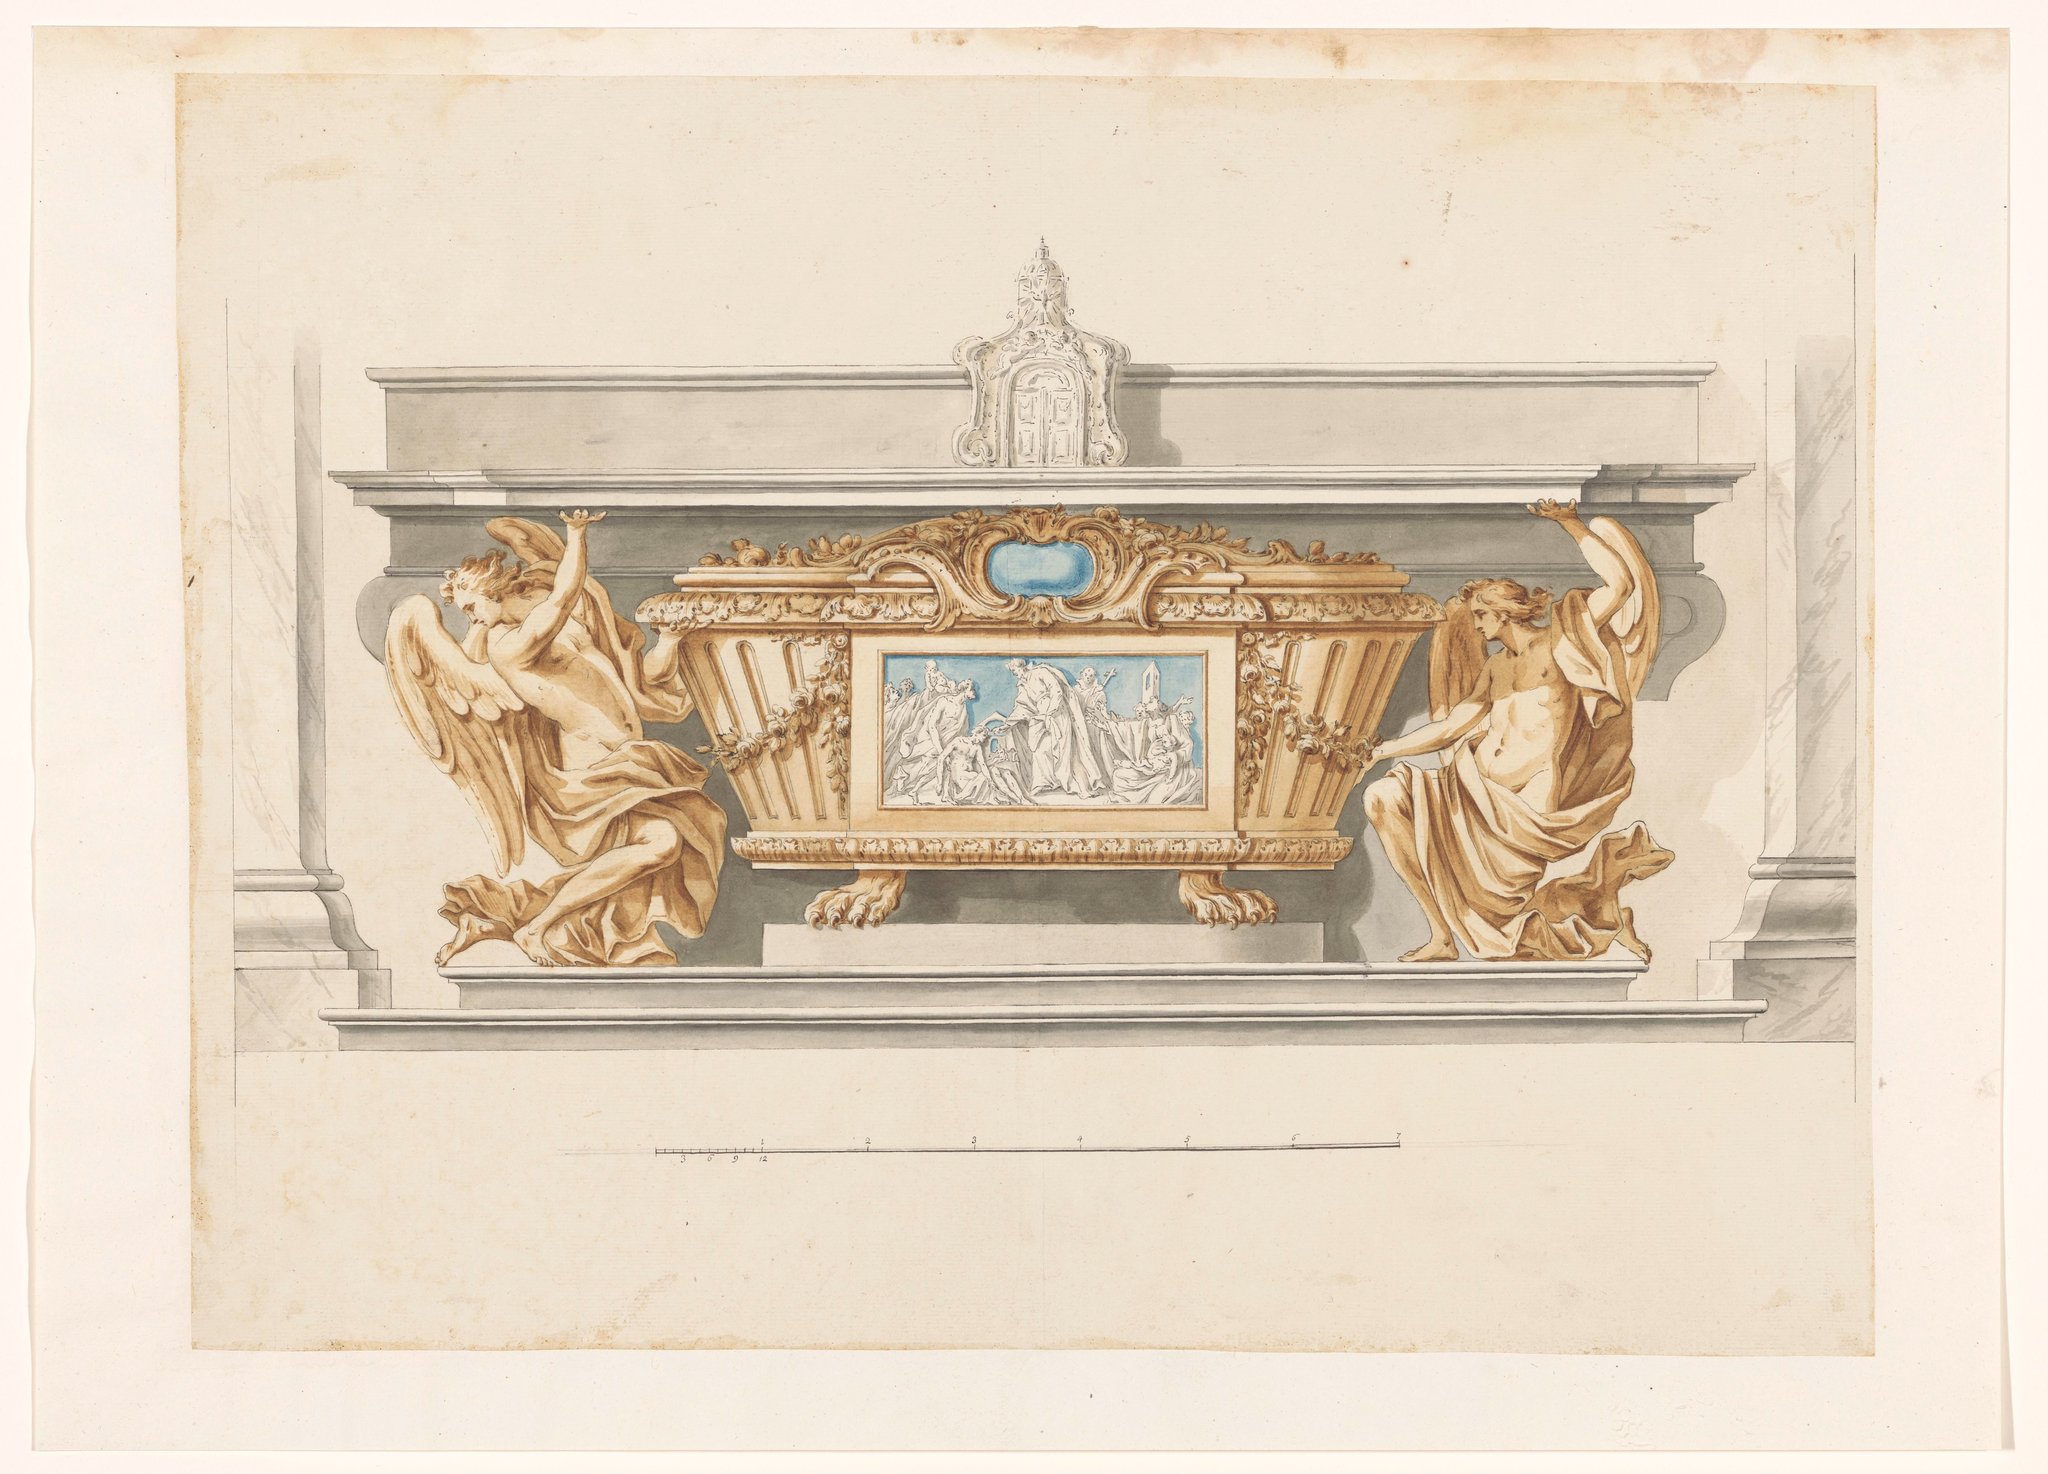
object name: design drawing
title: Ontwerp voor het altaar van de heilige Camillo de Lellis voor de Santa Maria Maddalena in Rome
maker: luigi valadier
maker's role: draughtsman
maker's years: 1726-1785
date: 1770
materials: graphite, ink, paper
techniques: brush, pen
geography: rome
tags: altar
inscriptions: inscription